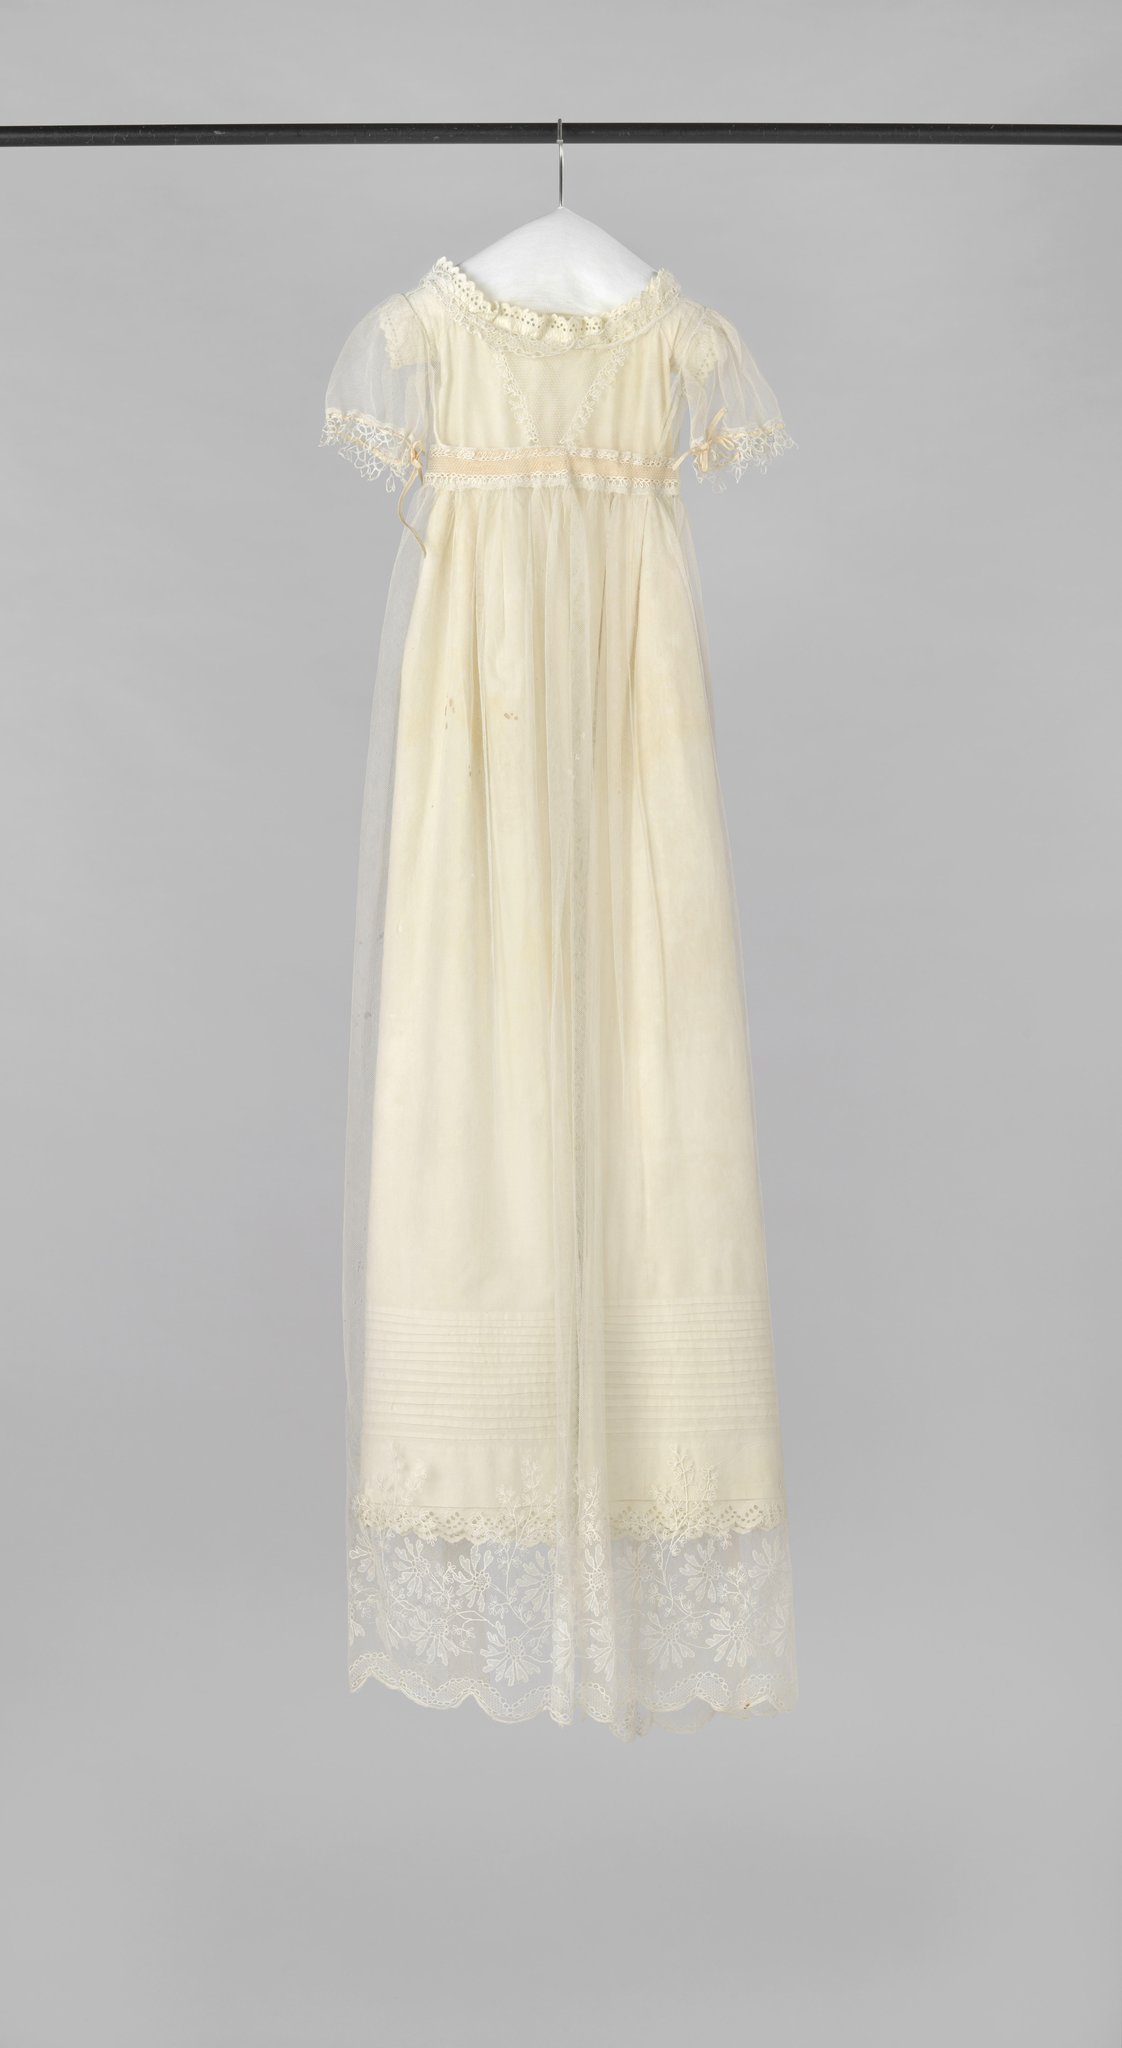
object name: childrenswear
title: Doopjurk van tulle doorstop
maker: Anonymous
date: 1825-1835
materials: fiber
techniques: stopwork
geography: netherlands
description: Doopjurk, Biedermeier, van tulle doorstop. Model: gerimpelde rok (van bruidssluier gemaakt?) met glad lijf met gerimpelde boothals en met pofmouwen. Gladde, brede, dubbele ceintuurband voor rijglint van beige satijn. Geborduurd met brede rand van bloemen aan slingerende takken met tien bladtakken. Flauw geschulpte rand met doorstopwerk. Op lijf ook doorgestopte driehoek. Met kant afgezet langs hals en pofmouwen, type: Beckinghamshire. Nederland, ca. 1825-1835.